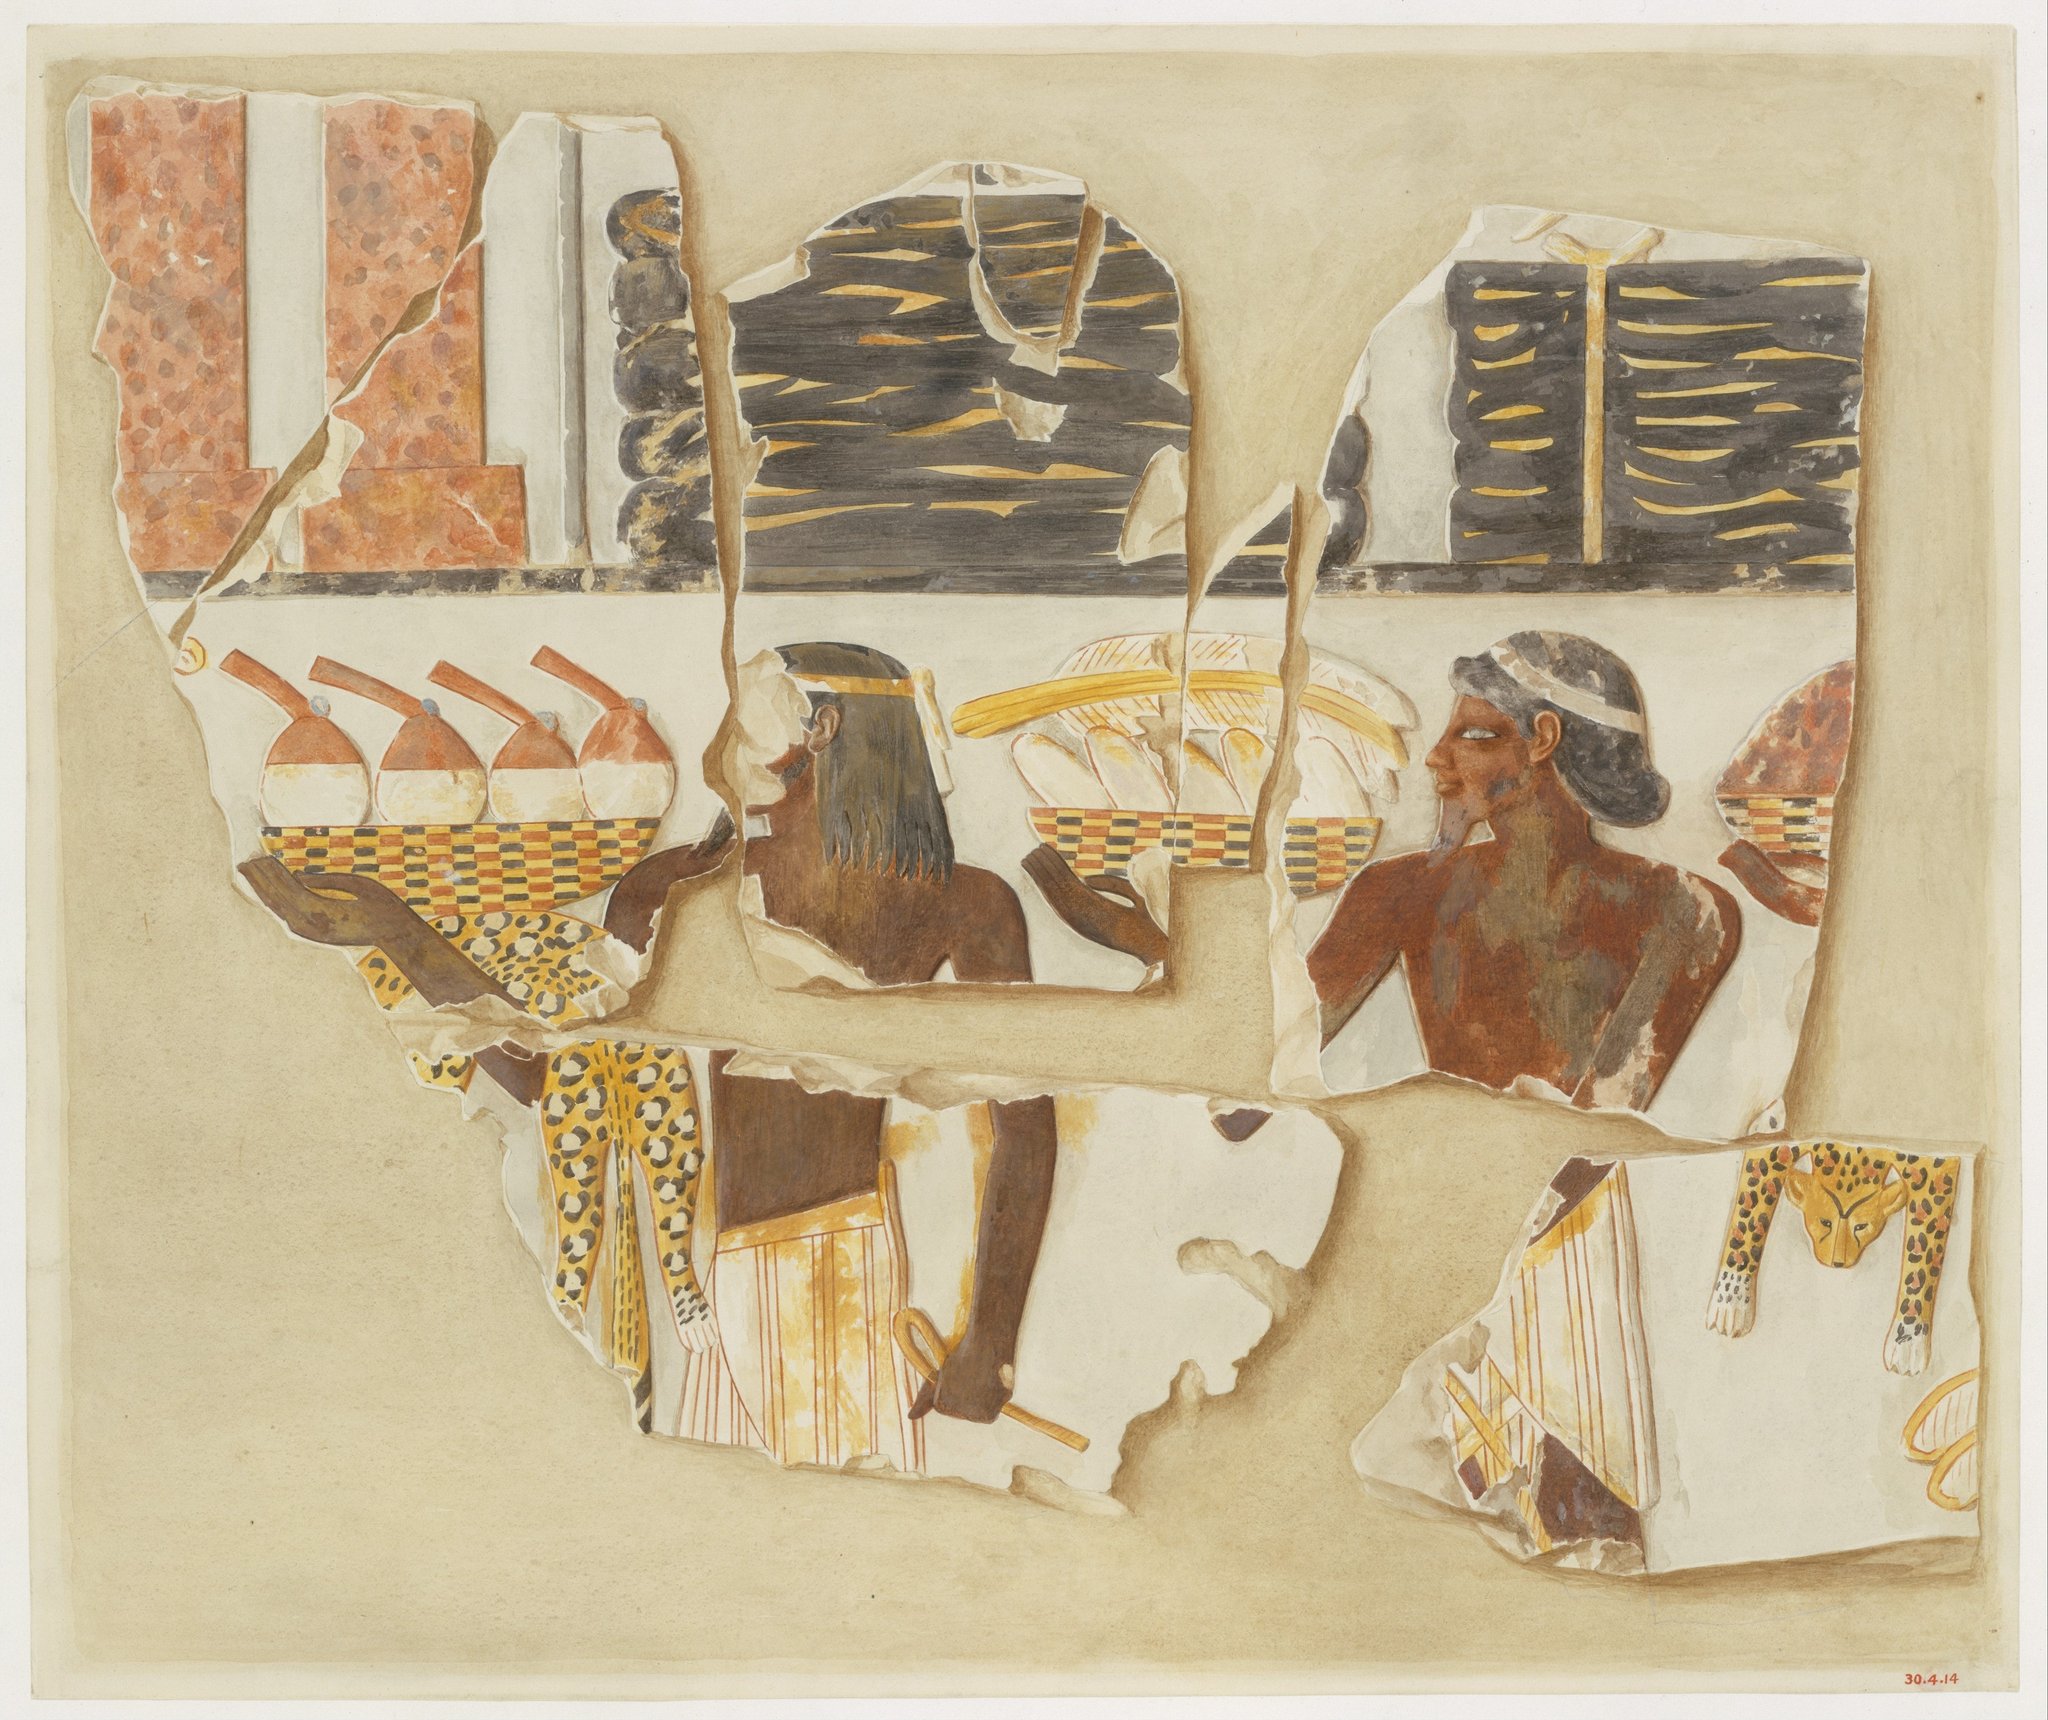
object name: facsimile, puyemre tt 39, asian, gift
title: Asians Bringing Gifts from the East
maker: hugh r. hopgood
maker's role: artist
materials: paper, paint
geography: egypt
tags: men,walk-like-egyptian